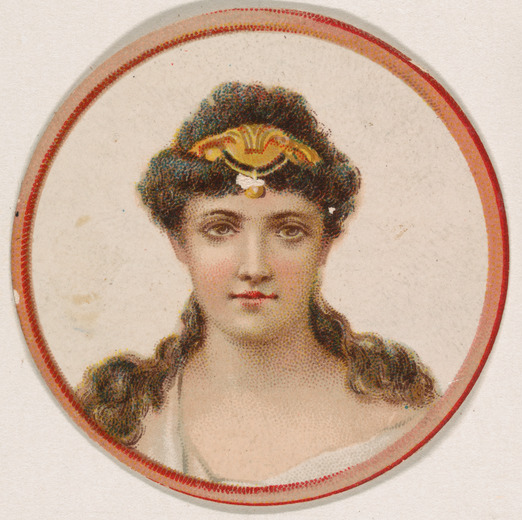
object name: print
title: Portrait of woman, from the Novelties series (N228, Type 2) issued by Kinney Bros.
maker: kinney brothers tobacco company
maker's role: publisher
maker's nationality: american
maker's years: 1869-2011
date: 1889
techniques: color lithograph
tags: portraits,women